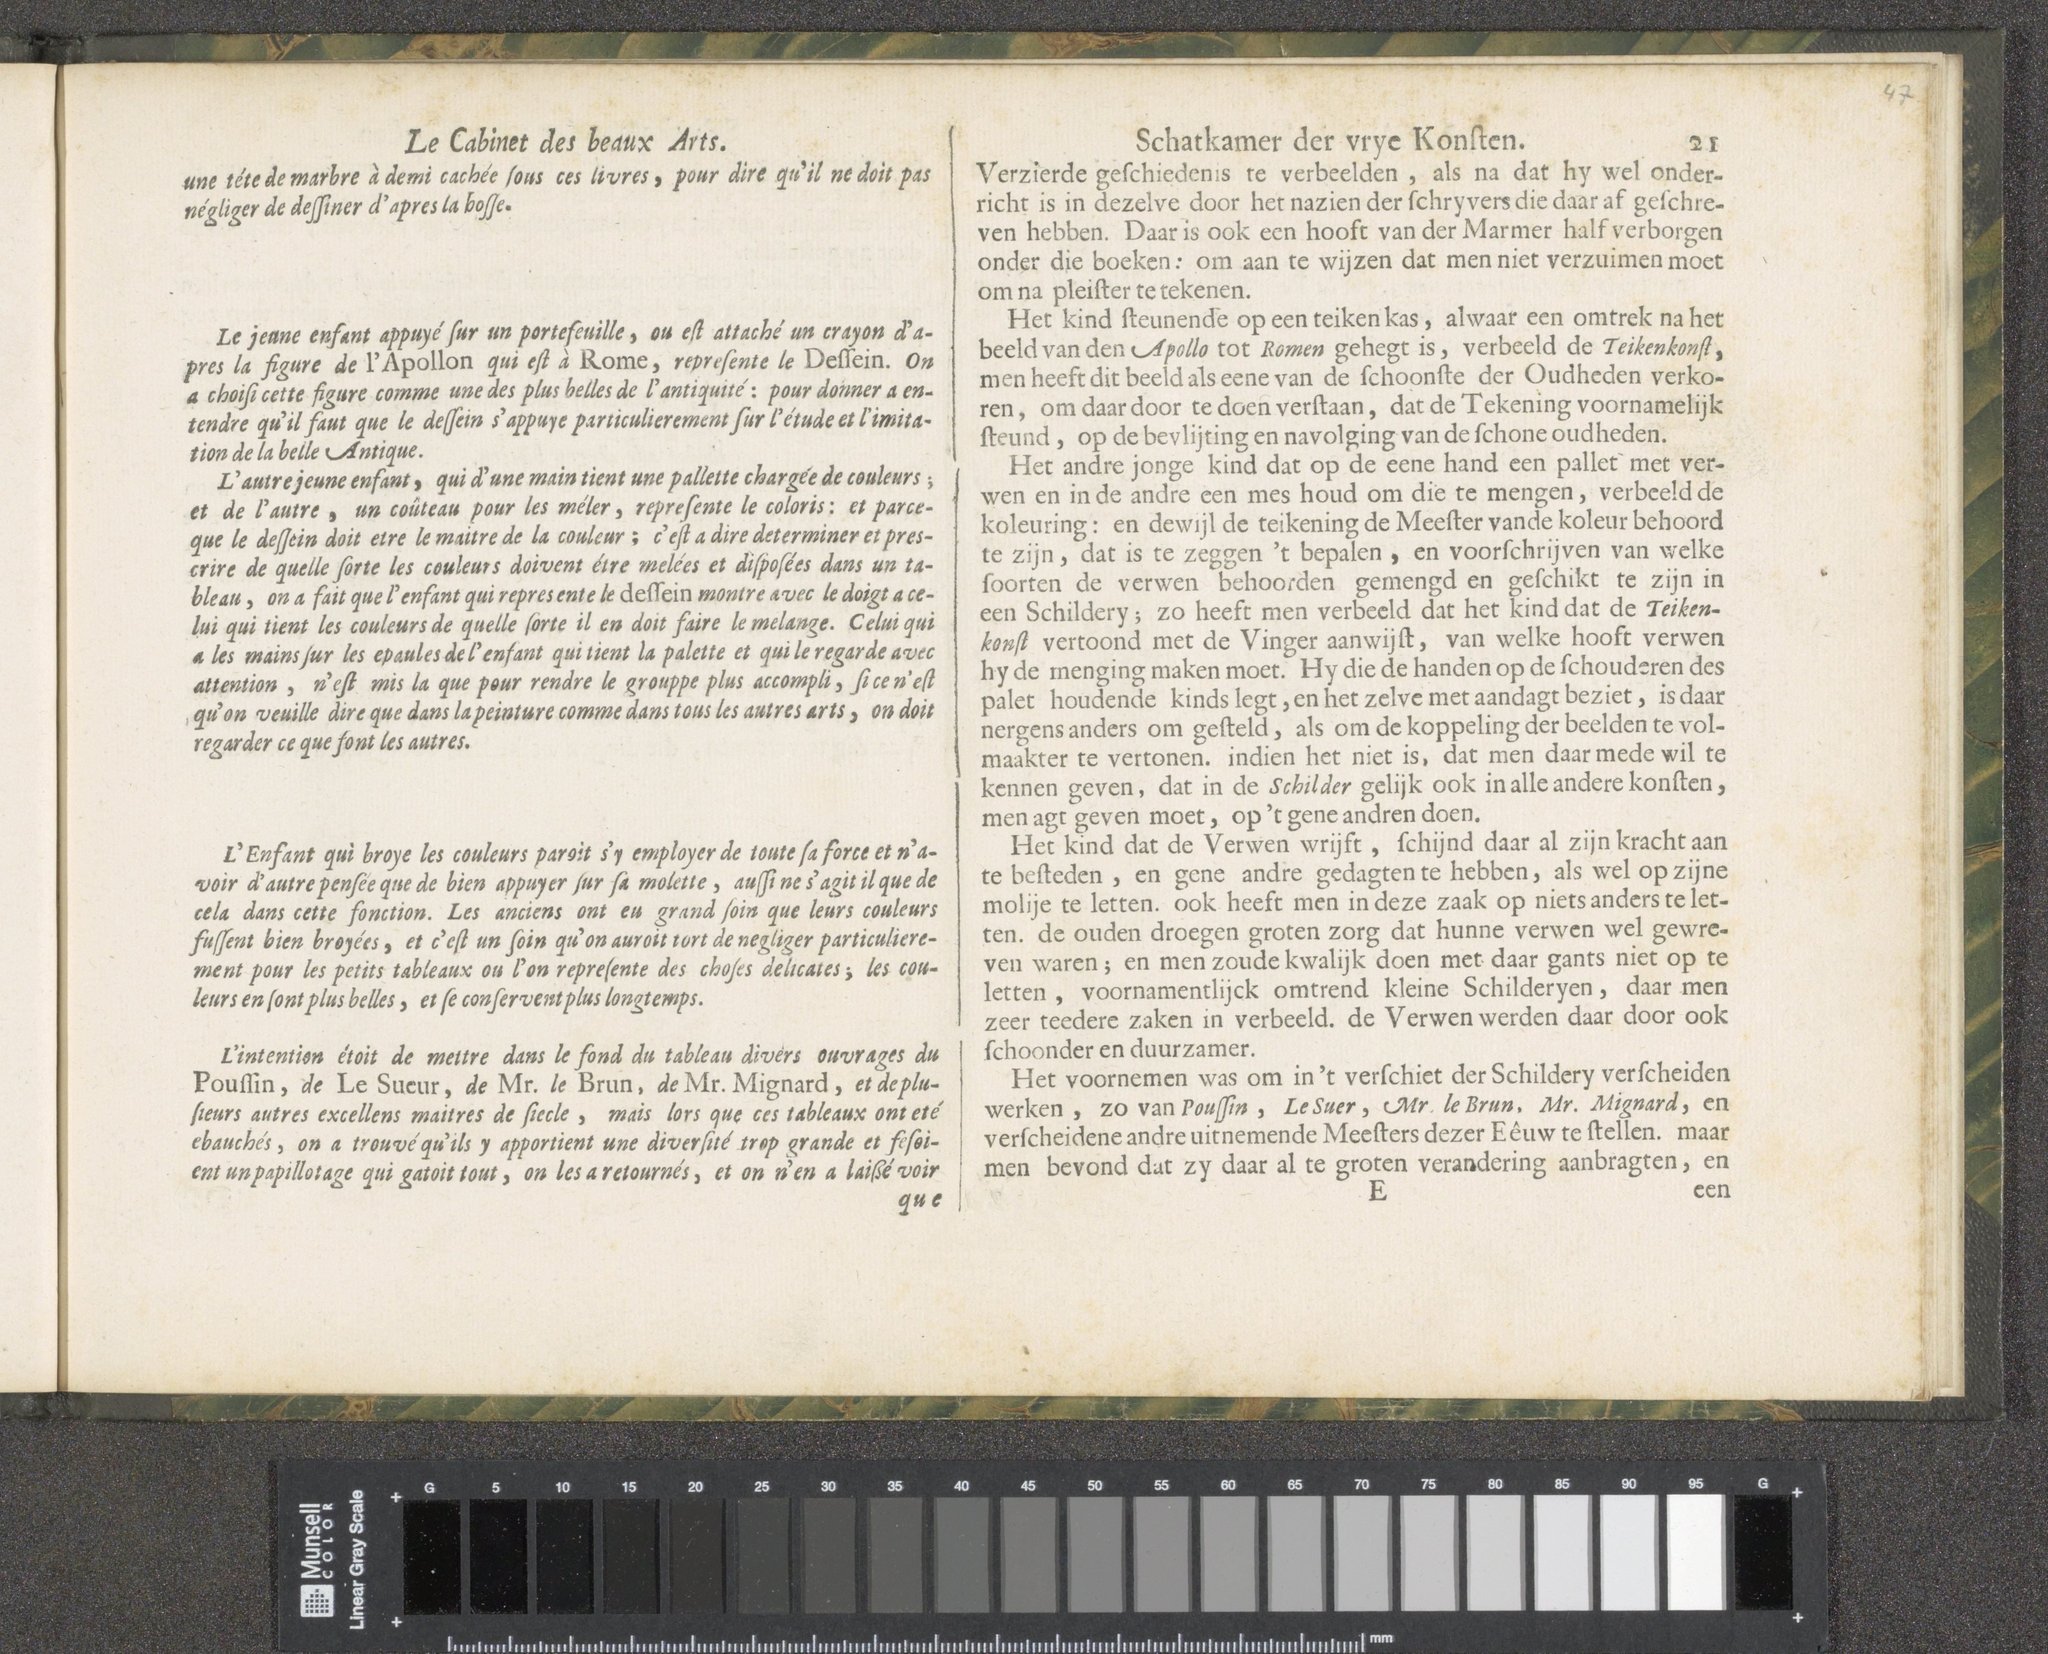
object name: text sheet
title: Tekstblad over de Schilderkunst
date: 1693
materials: paper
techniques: letterpress printing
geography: amsterdam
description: Verklaring van de prent met de voorstelling van de personificatie van Schilderkunst in het Frans en het Nederlands, pagina 21. Tekstblad maakt deel uit van een album.